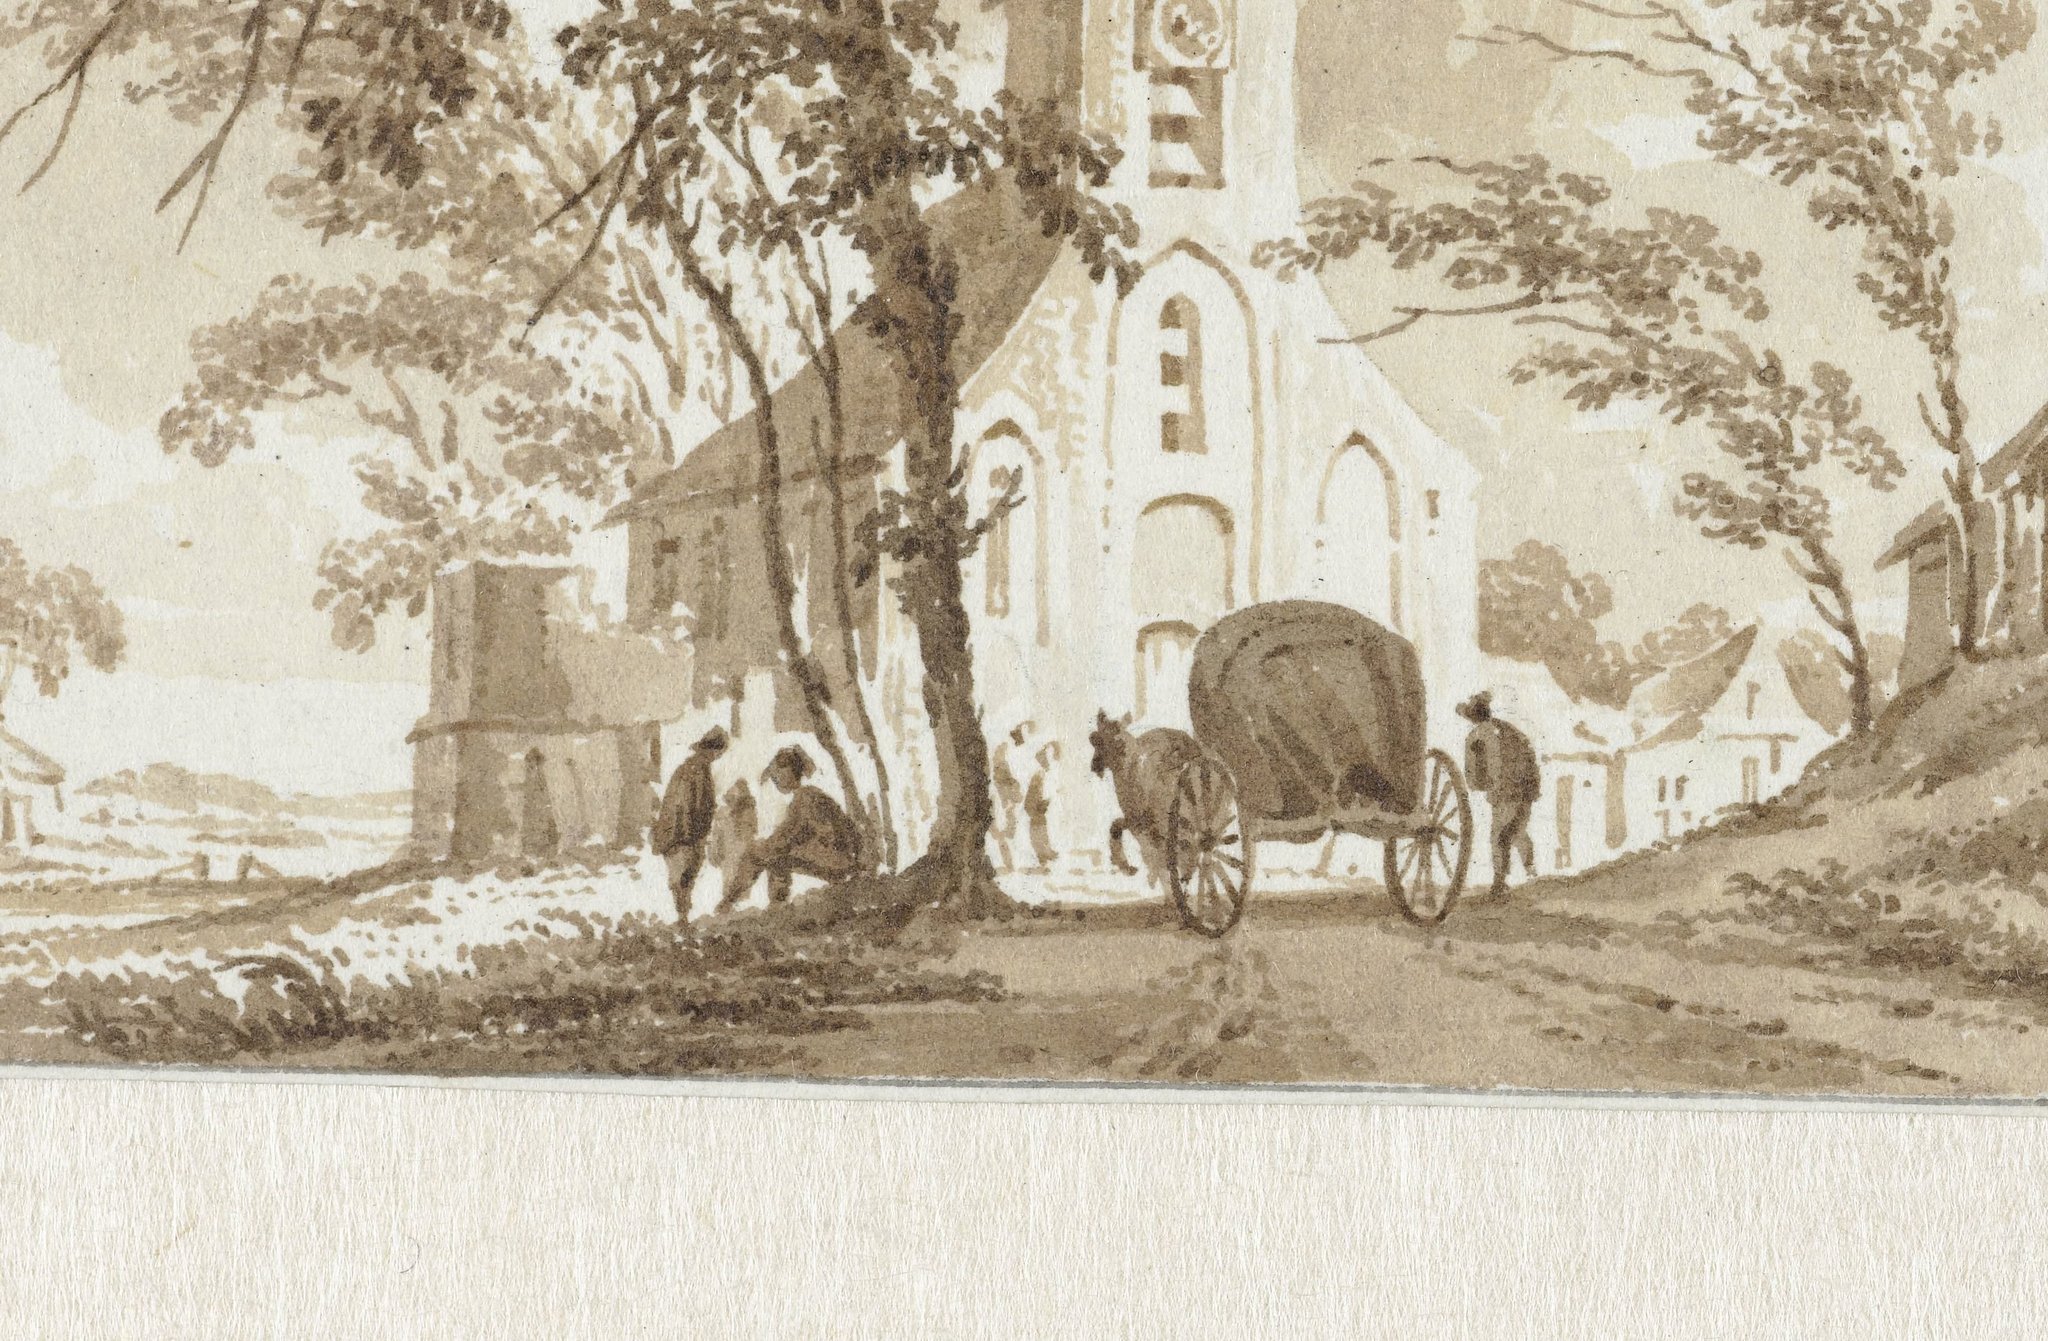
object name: drawing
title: Dorpskerk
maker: paulus van liender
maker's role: draughtsman, print maker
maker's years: 1731-1797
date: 1776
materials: ink, paper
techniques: brush, pen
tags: church (exterior)